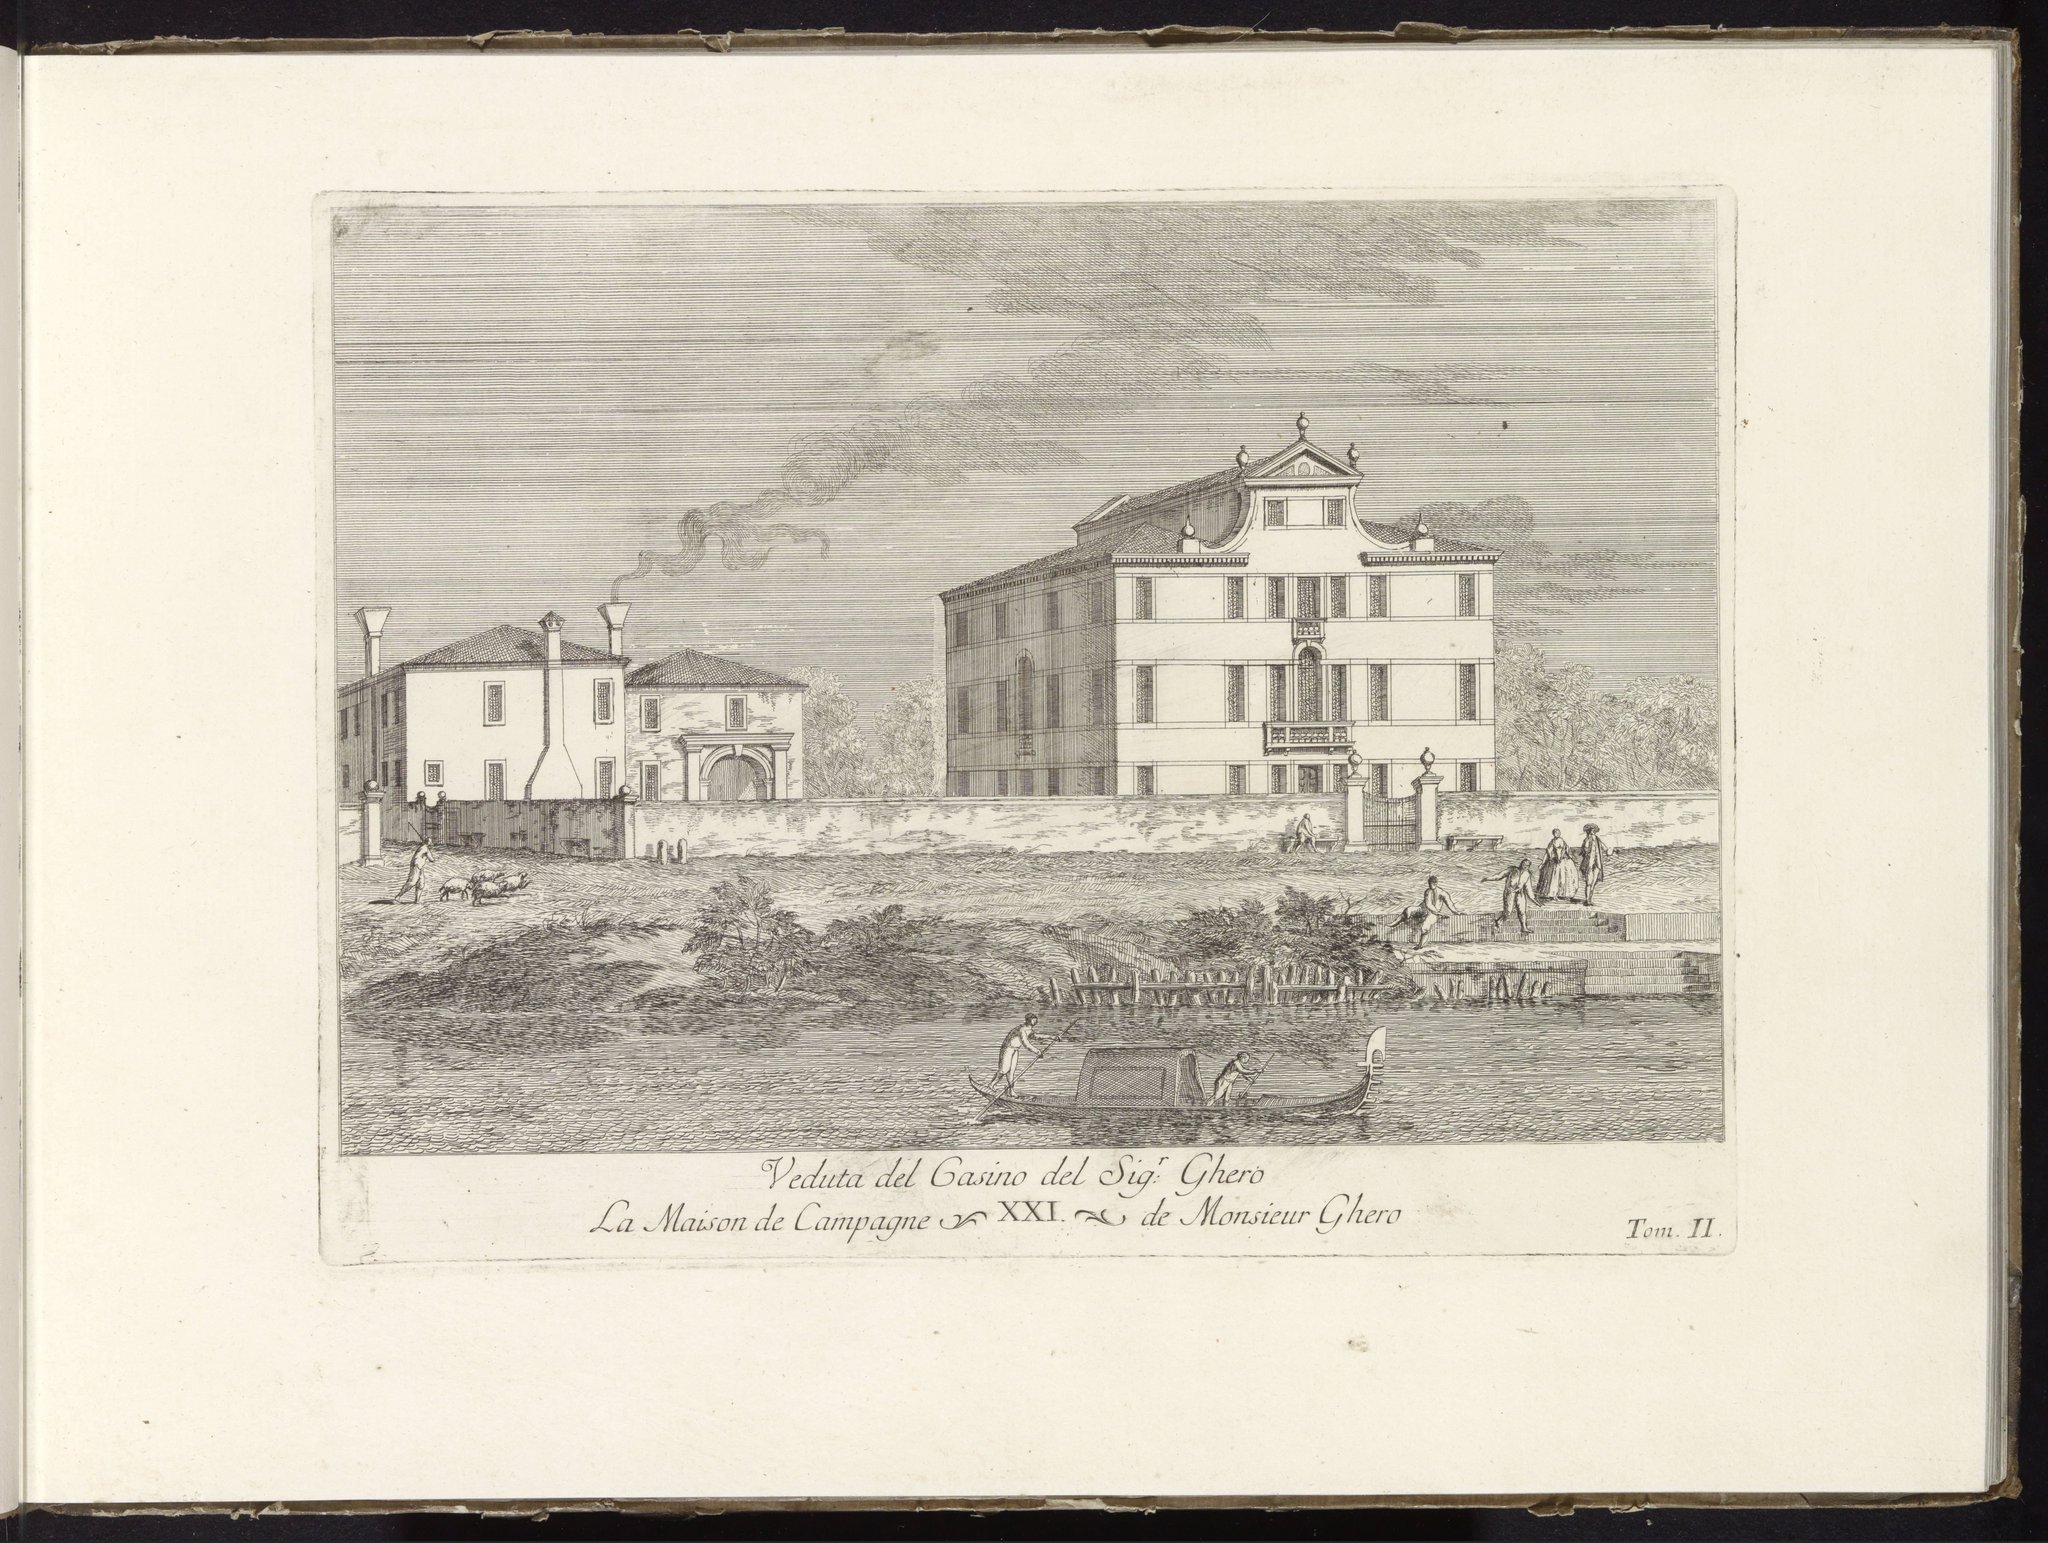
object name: print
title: Gezichten op de rivier de Brenta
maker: giovanni francesco costa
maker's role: draughtsman, painter, print maker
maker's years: -1773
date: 1750-1760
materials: paper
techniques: etching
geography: venice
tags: river, hôtel, i.e. small palace in city, gondola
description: Gezicht op Casino del Signore Ghero aan de rivier de Brenta. Op het water vaart een gondel. Rustende figuren zitten aan de waterkant. Genummerd midden onder: XXI en rechtsonder: Tom: II. Deze prent maakt deel uit van een album.